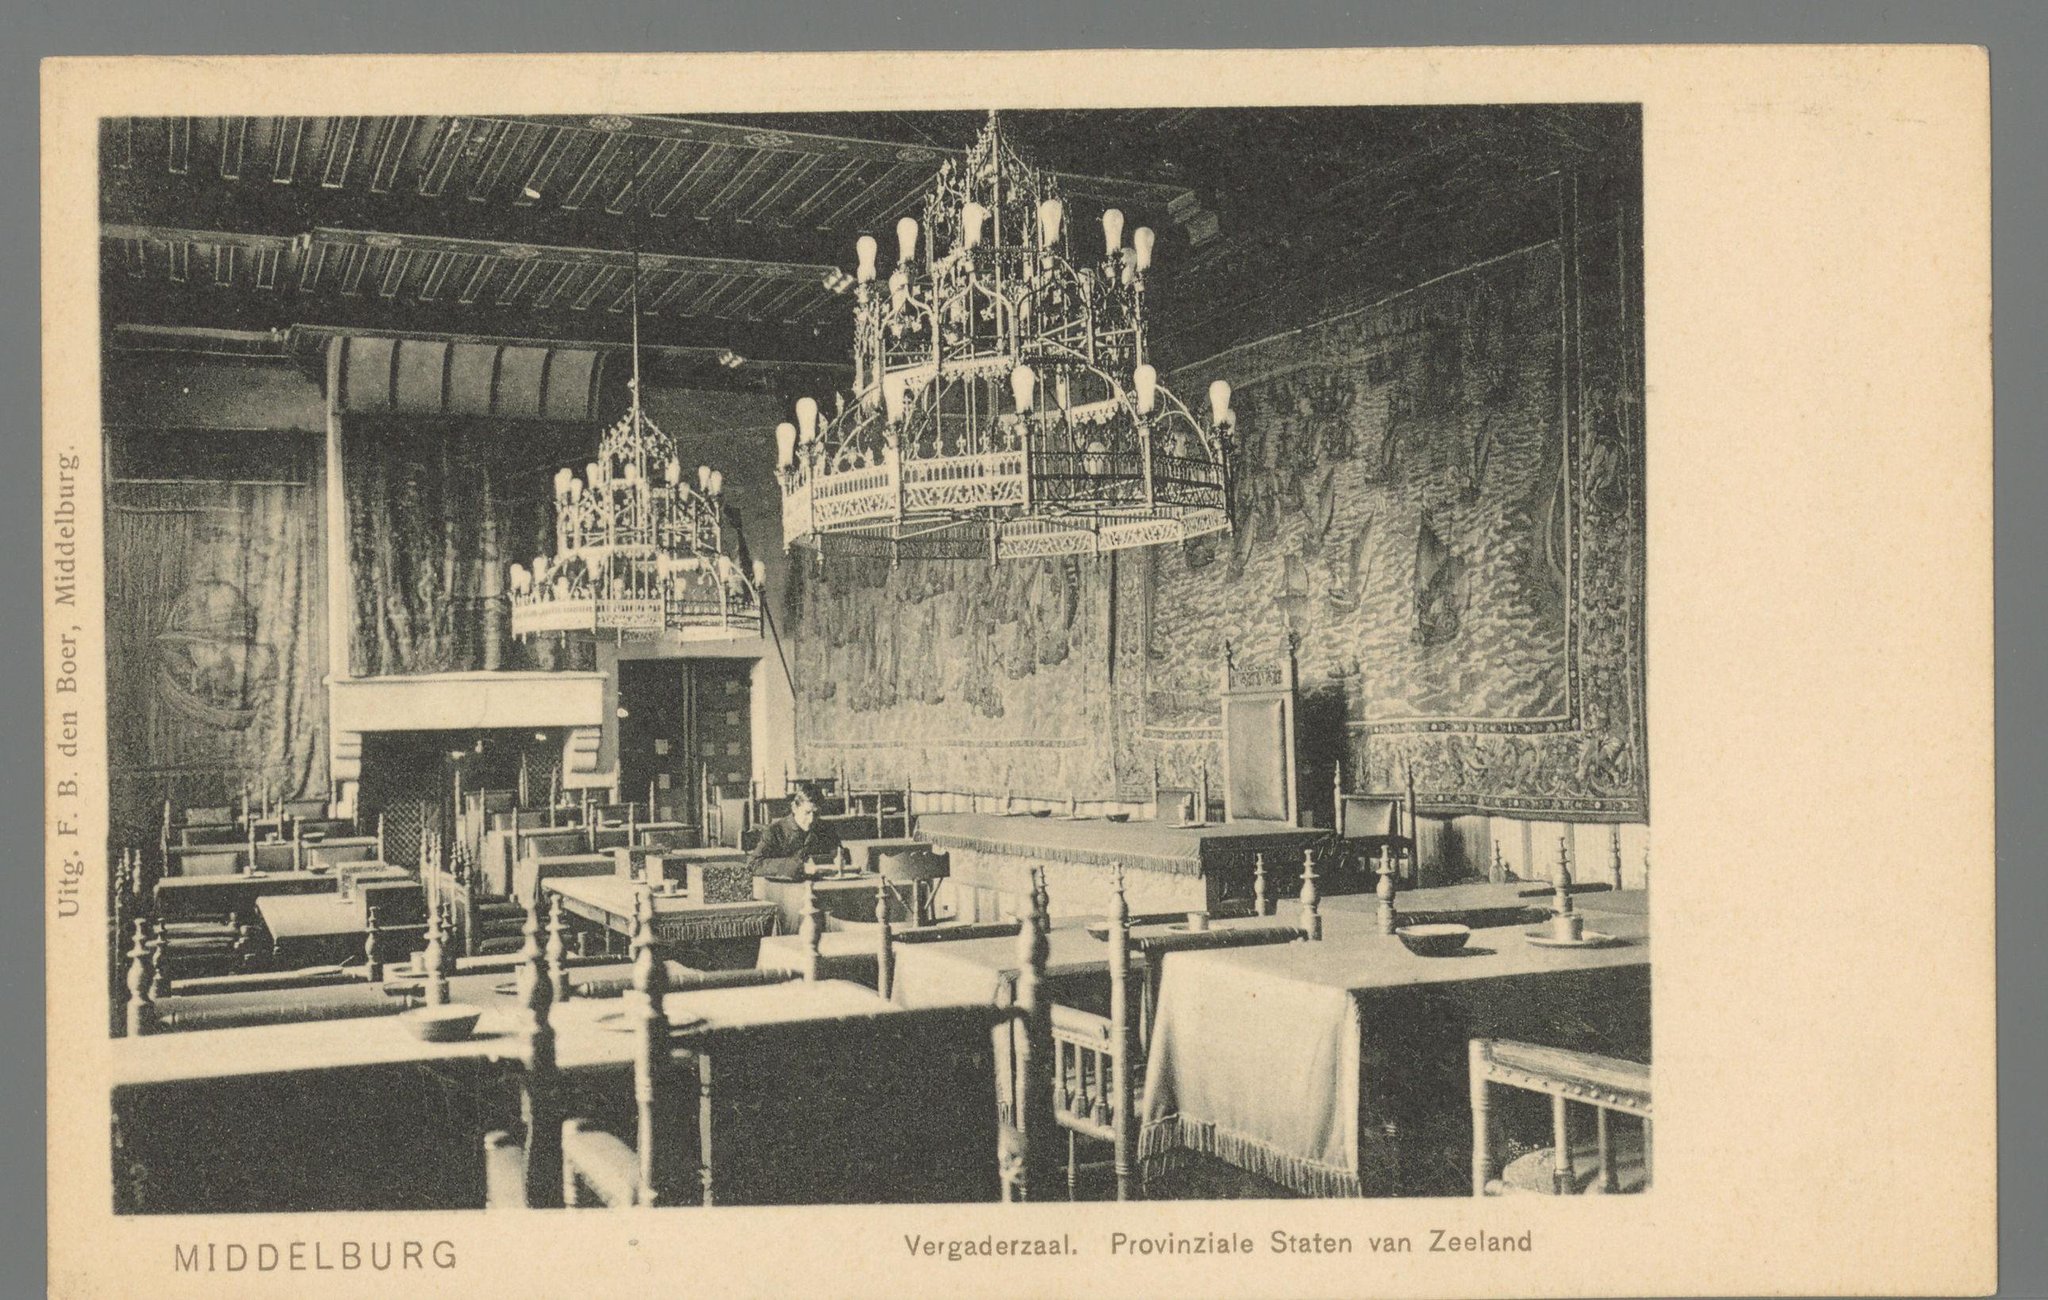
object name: photomechanical print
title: Middelburg. Vergaderzaal. Provinziale Staten van Zeeland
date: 1905-1930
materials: cardboard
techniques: photograph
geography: middelburg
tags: club, meeting place